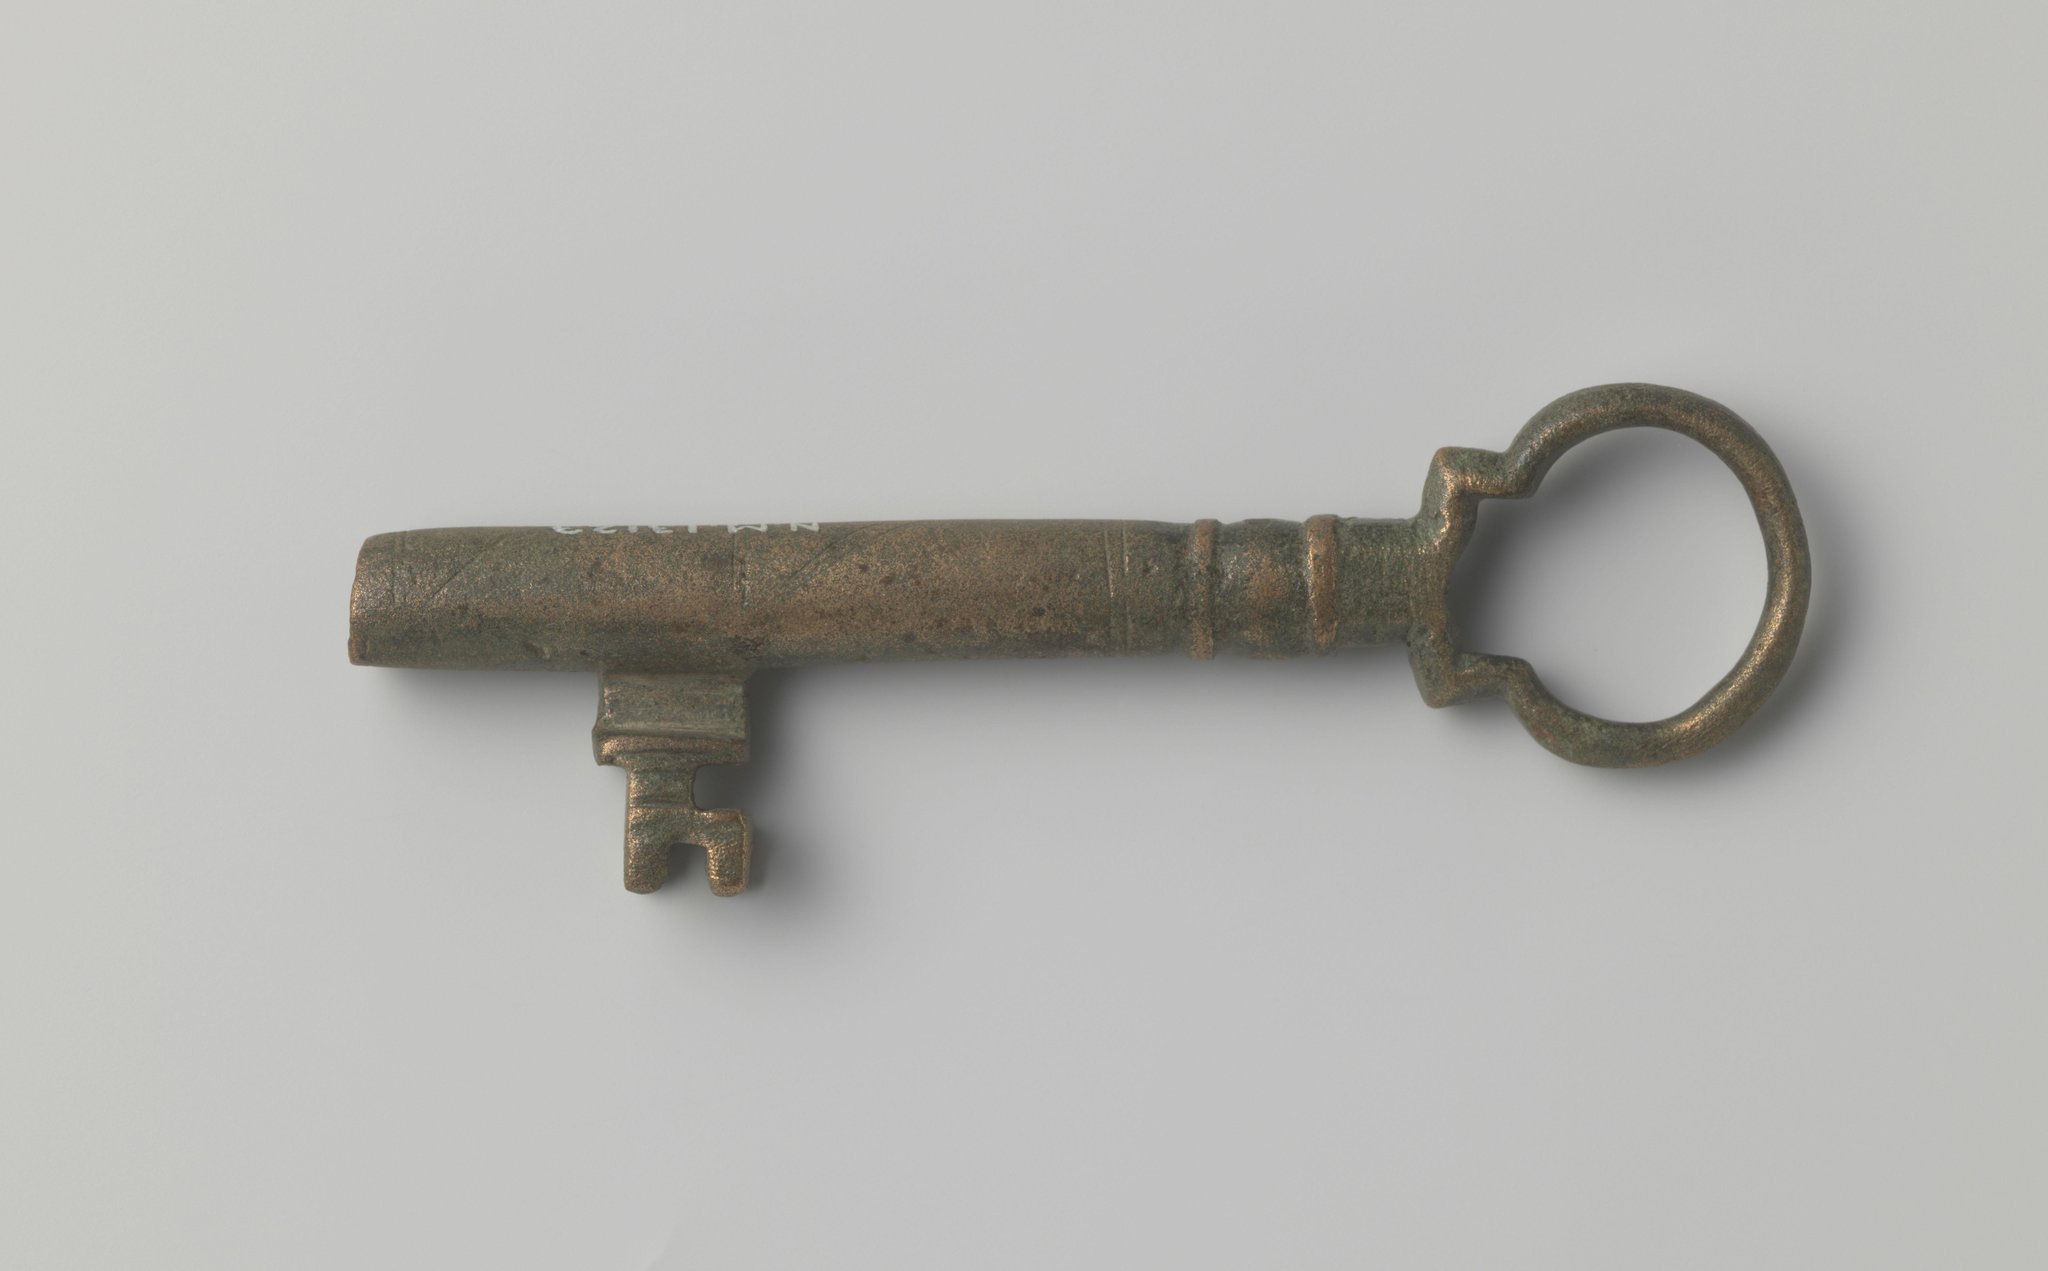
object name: key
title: Sleutel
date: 1300-1400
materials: bronze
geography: france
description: Bronzen sleutel. Ring van boven rond, van onderen hoekig. Pijp geheel hol, met ingekraste dwars- en diagonaalstrepen versierd. Baard aan de zijkanten, van onderen en van voren ingesneden.